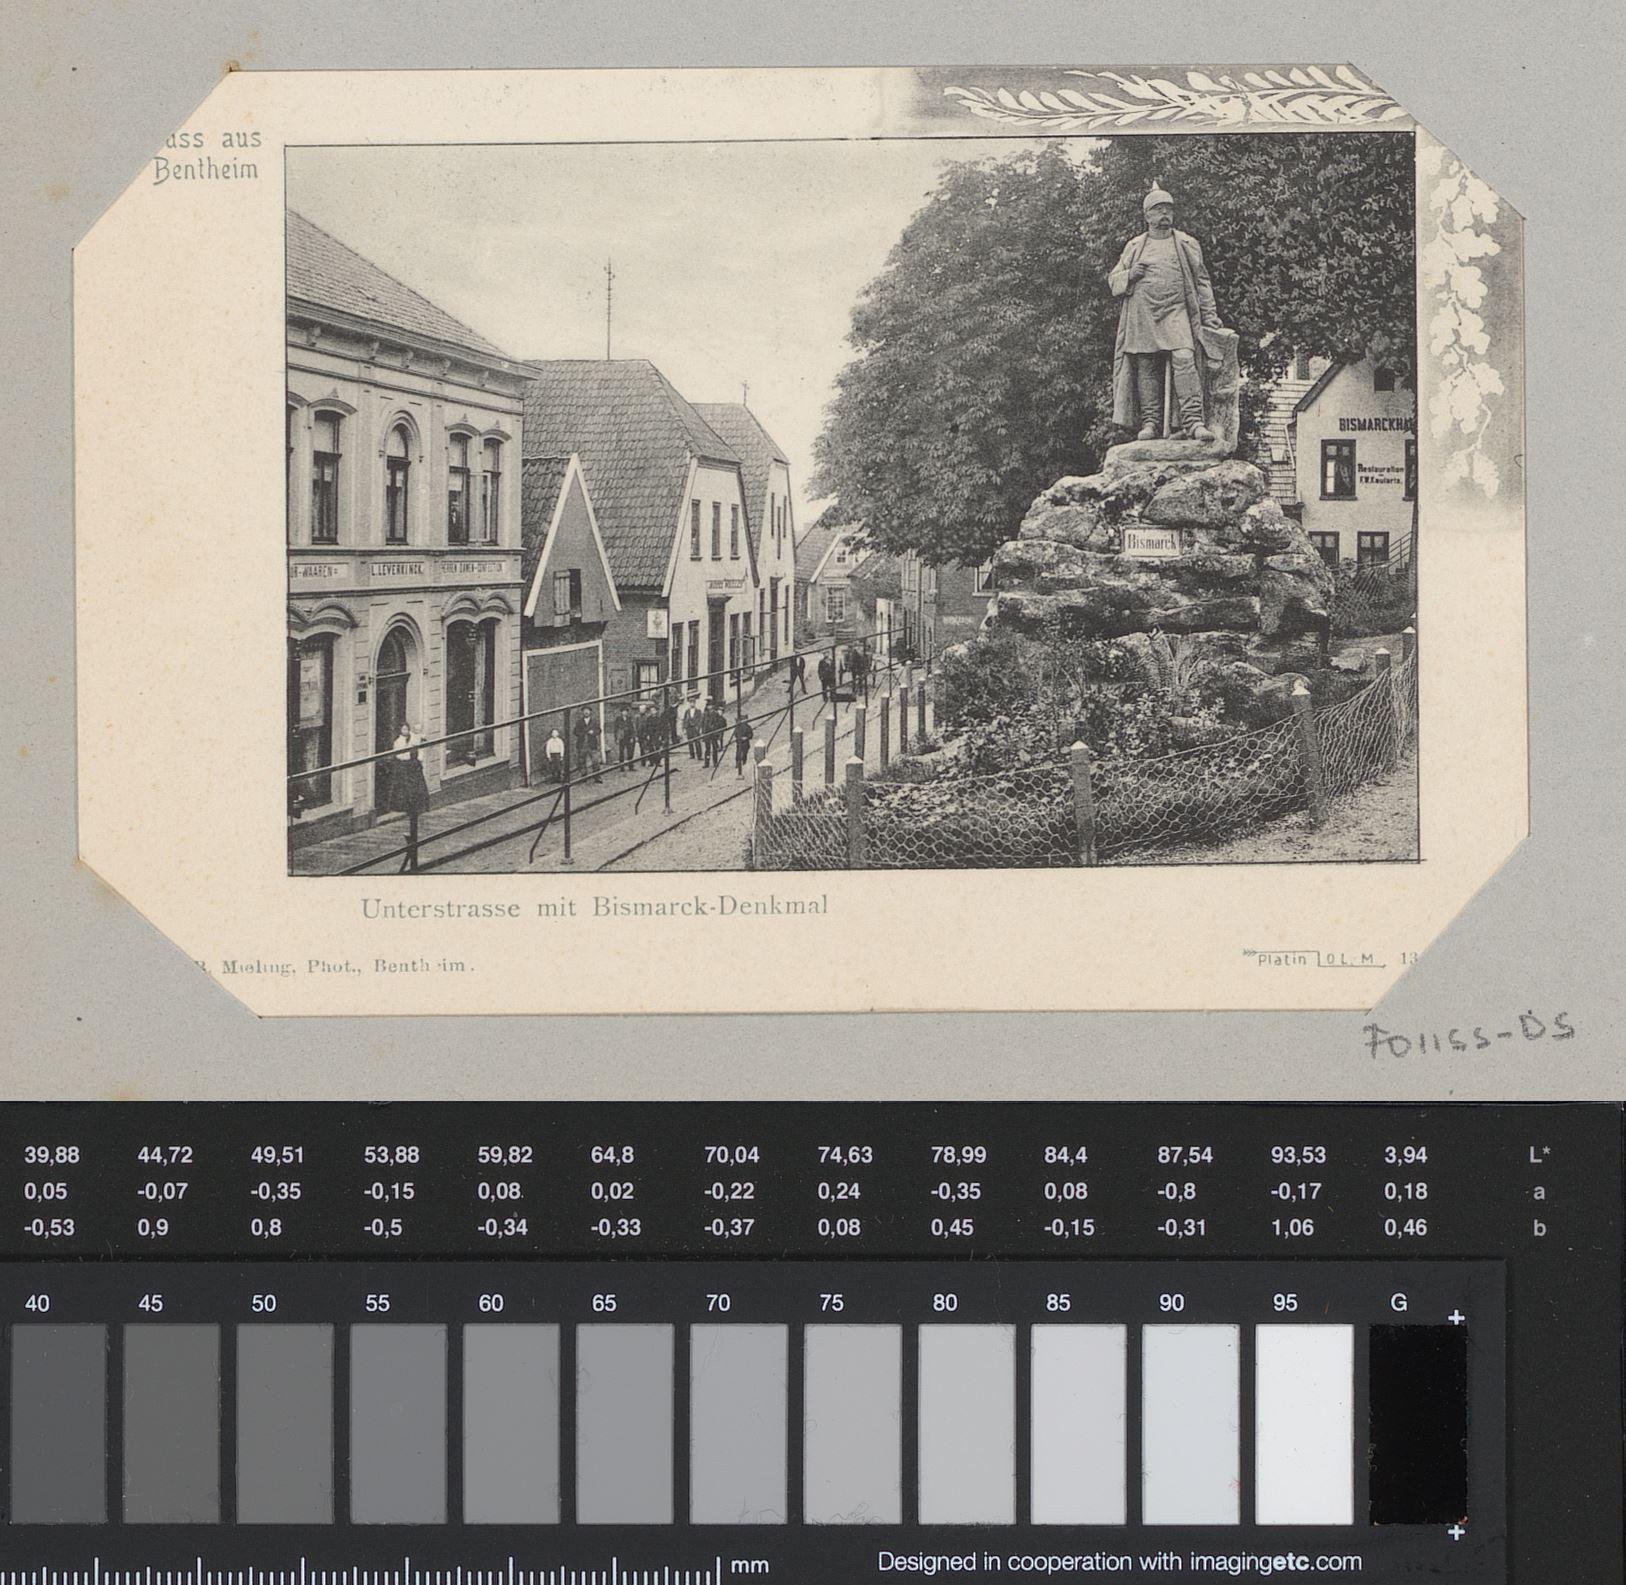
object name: photomechanical print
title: Gezicht op de Unterstrasse met het Bismarck-Denkmal te Bentheim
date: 1895-1903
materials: cardboard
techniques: photograph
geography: bentheim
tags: monument, statue, street (+ city(-scape) with figures, staffage)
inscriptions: inscription: ‘Gruss aus Bentheim/ Unterstrasse mit Bismarck-Denkmal/ Verlag B. Mieling, Phot., Bentheim/ [Platin OL M. 1340]’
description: Deze prent maakt deel uit van een album.